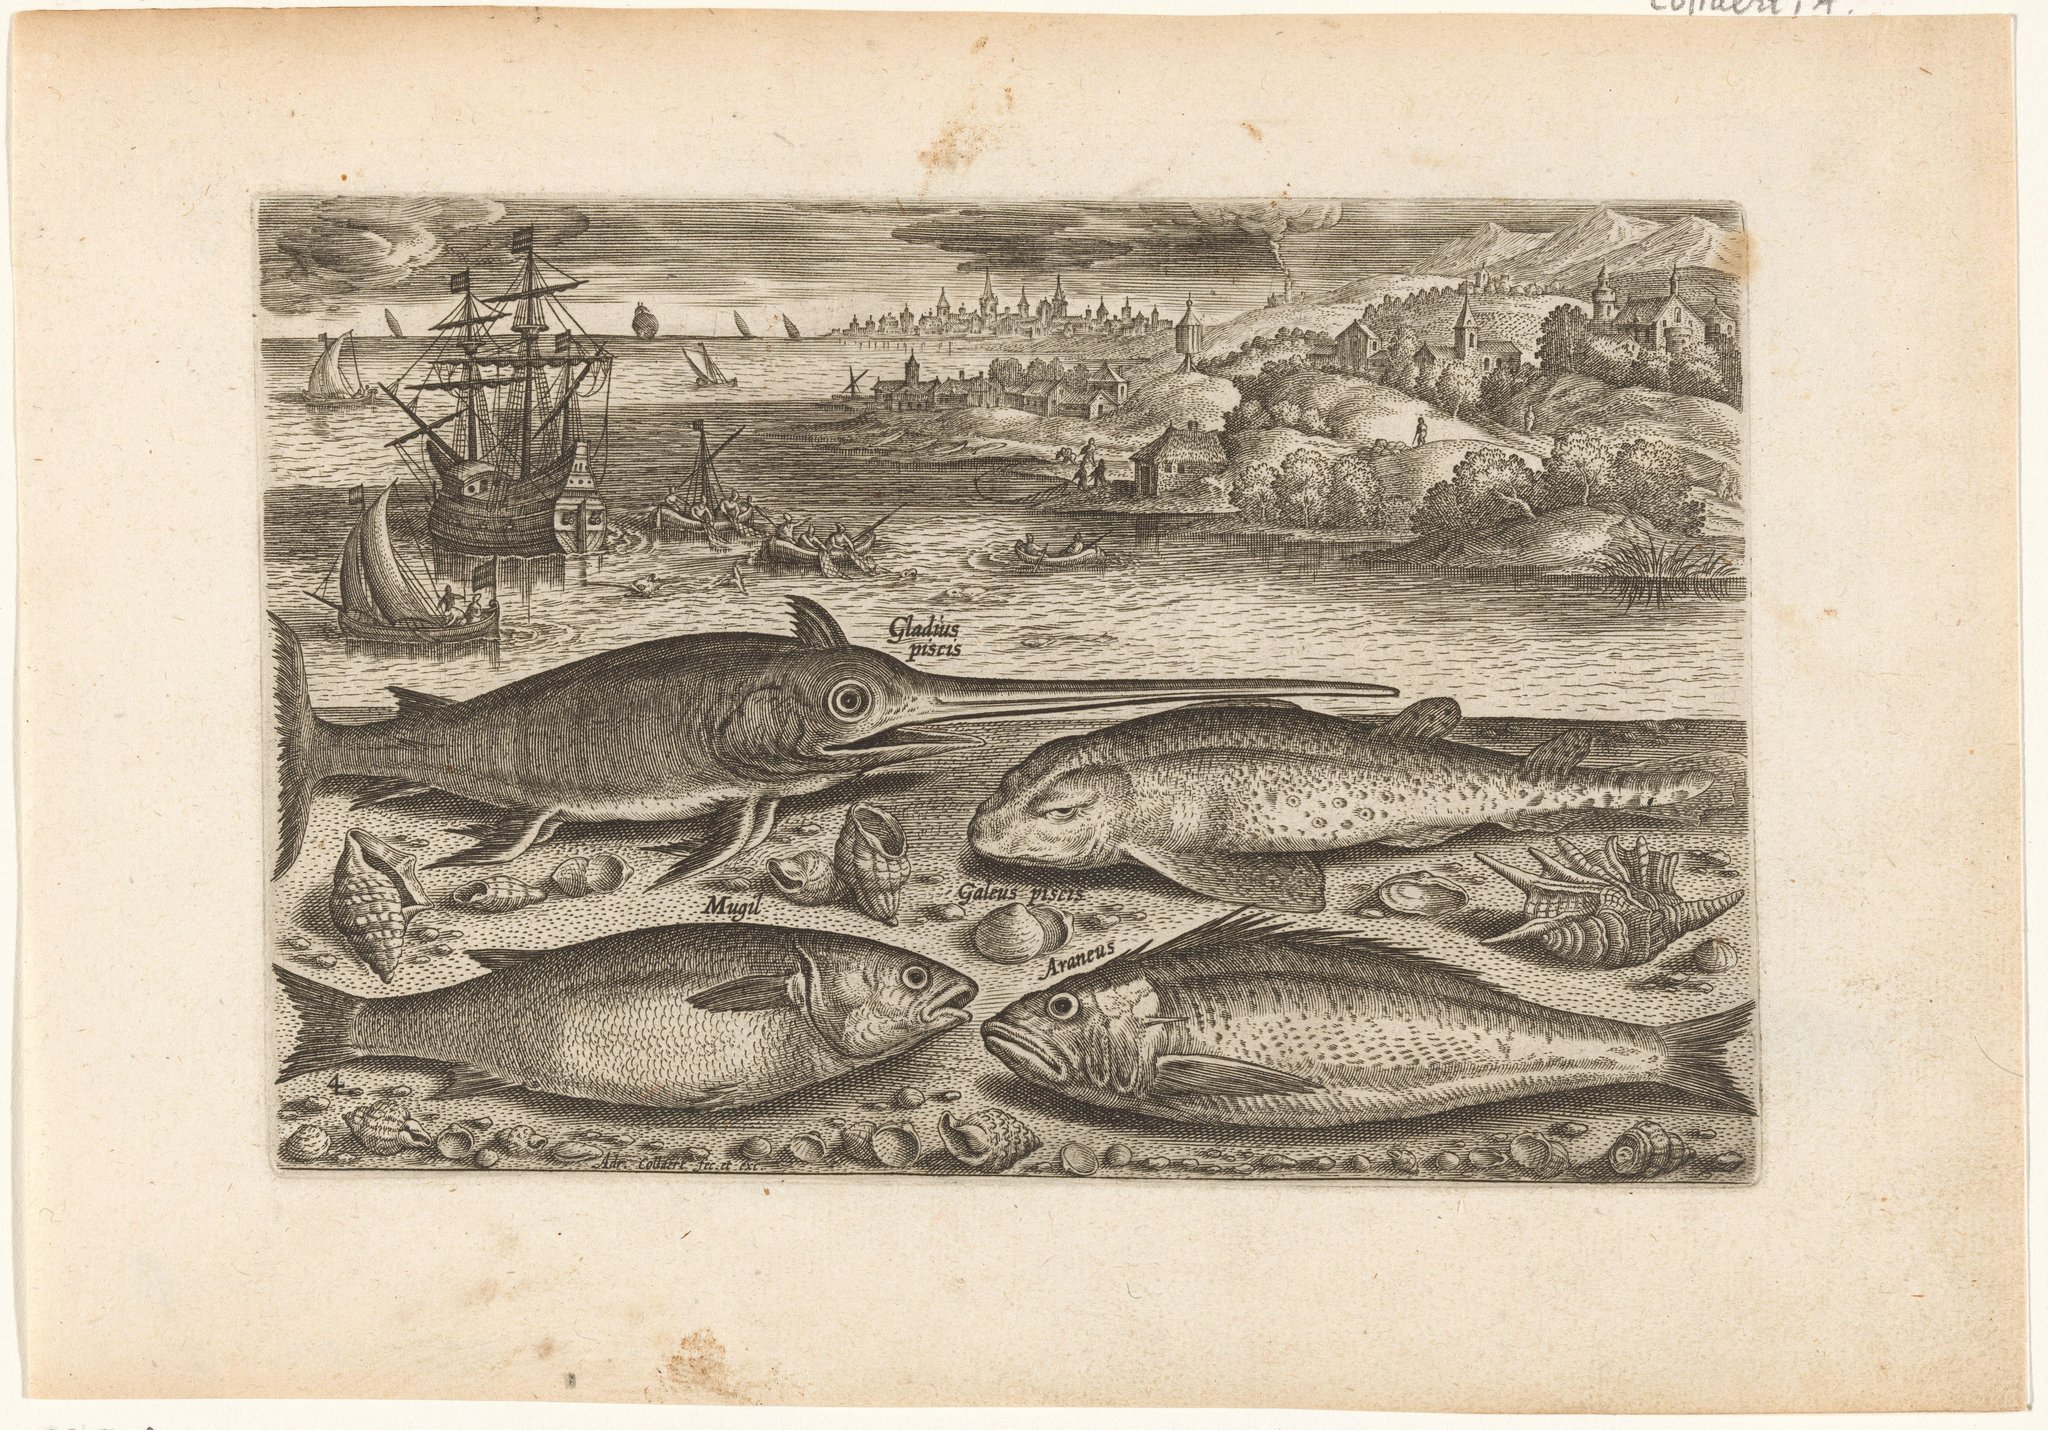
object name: print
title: Vier vissen op het strand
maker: adriaen collaert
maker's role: draughtsman, print maker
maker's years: 1560-1618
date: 1598-1618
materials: paper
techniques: engraving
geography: antwerp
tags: sea (seascape), bony fishes: mullet, bony fishes: sword-fish, cartilaginous fishes: dogfish, bony fishes: weever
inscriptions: number: ‘54/17’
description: Een zwaardvis, een harder, een kathaai en een pieterman liggen samen met wat schelpen aangespoeld op het strand. Op de achtergrond de zee en wat schepen. De prent maakt deel uit van een serie met vissen als onderwerp.